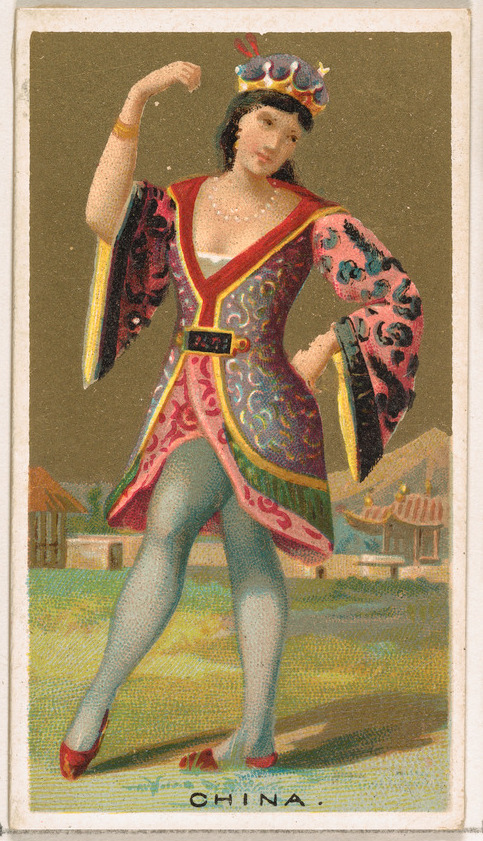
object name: print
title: China, from the Dancing Girls of the World series (N185) issued by Wm. S. Kimball & Co.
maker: william s. kimball & company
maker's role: publisher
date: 1889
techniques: color lithograph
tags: dance,girls,dancers